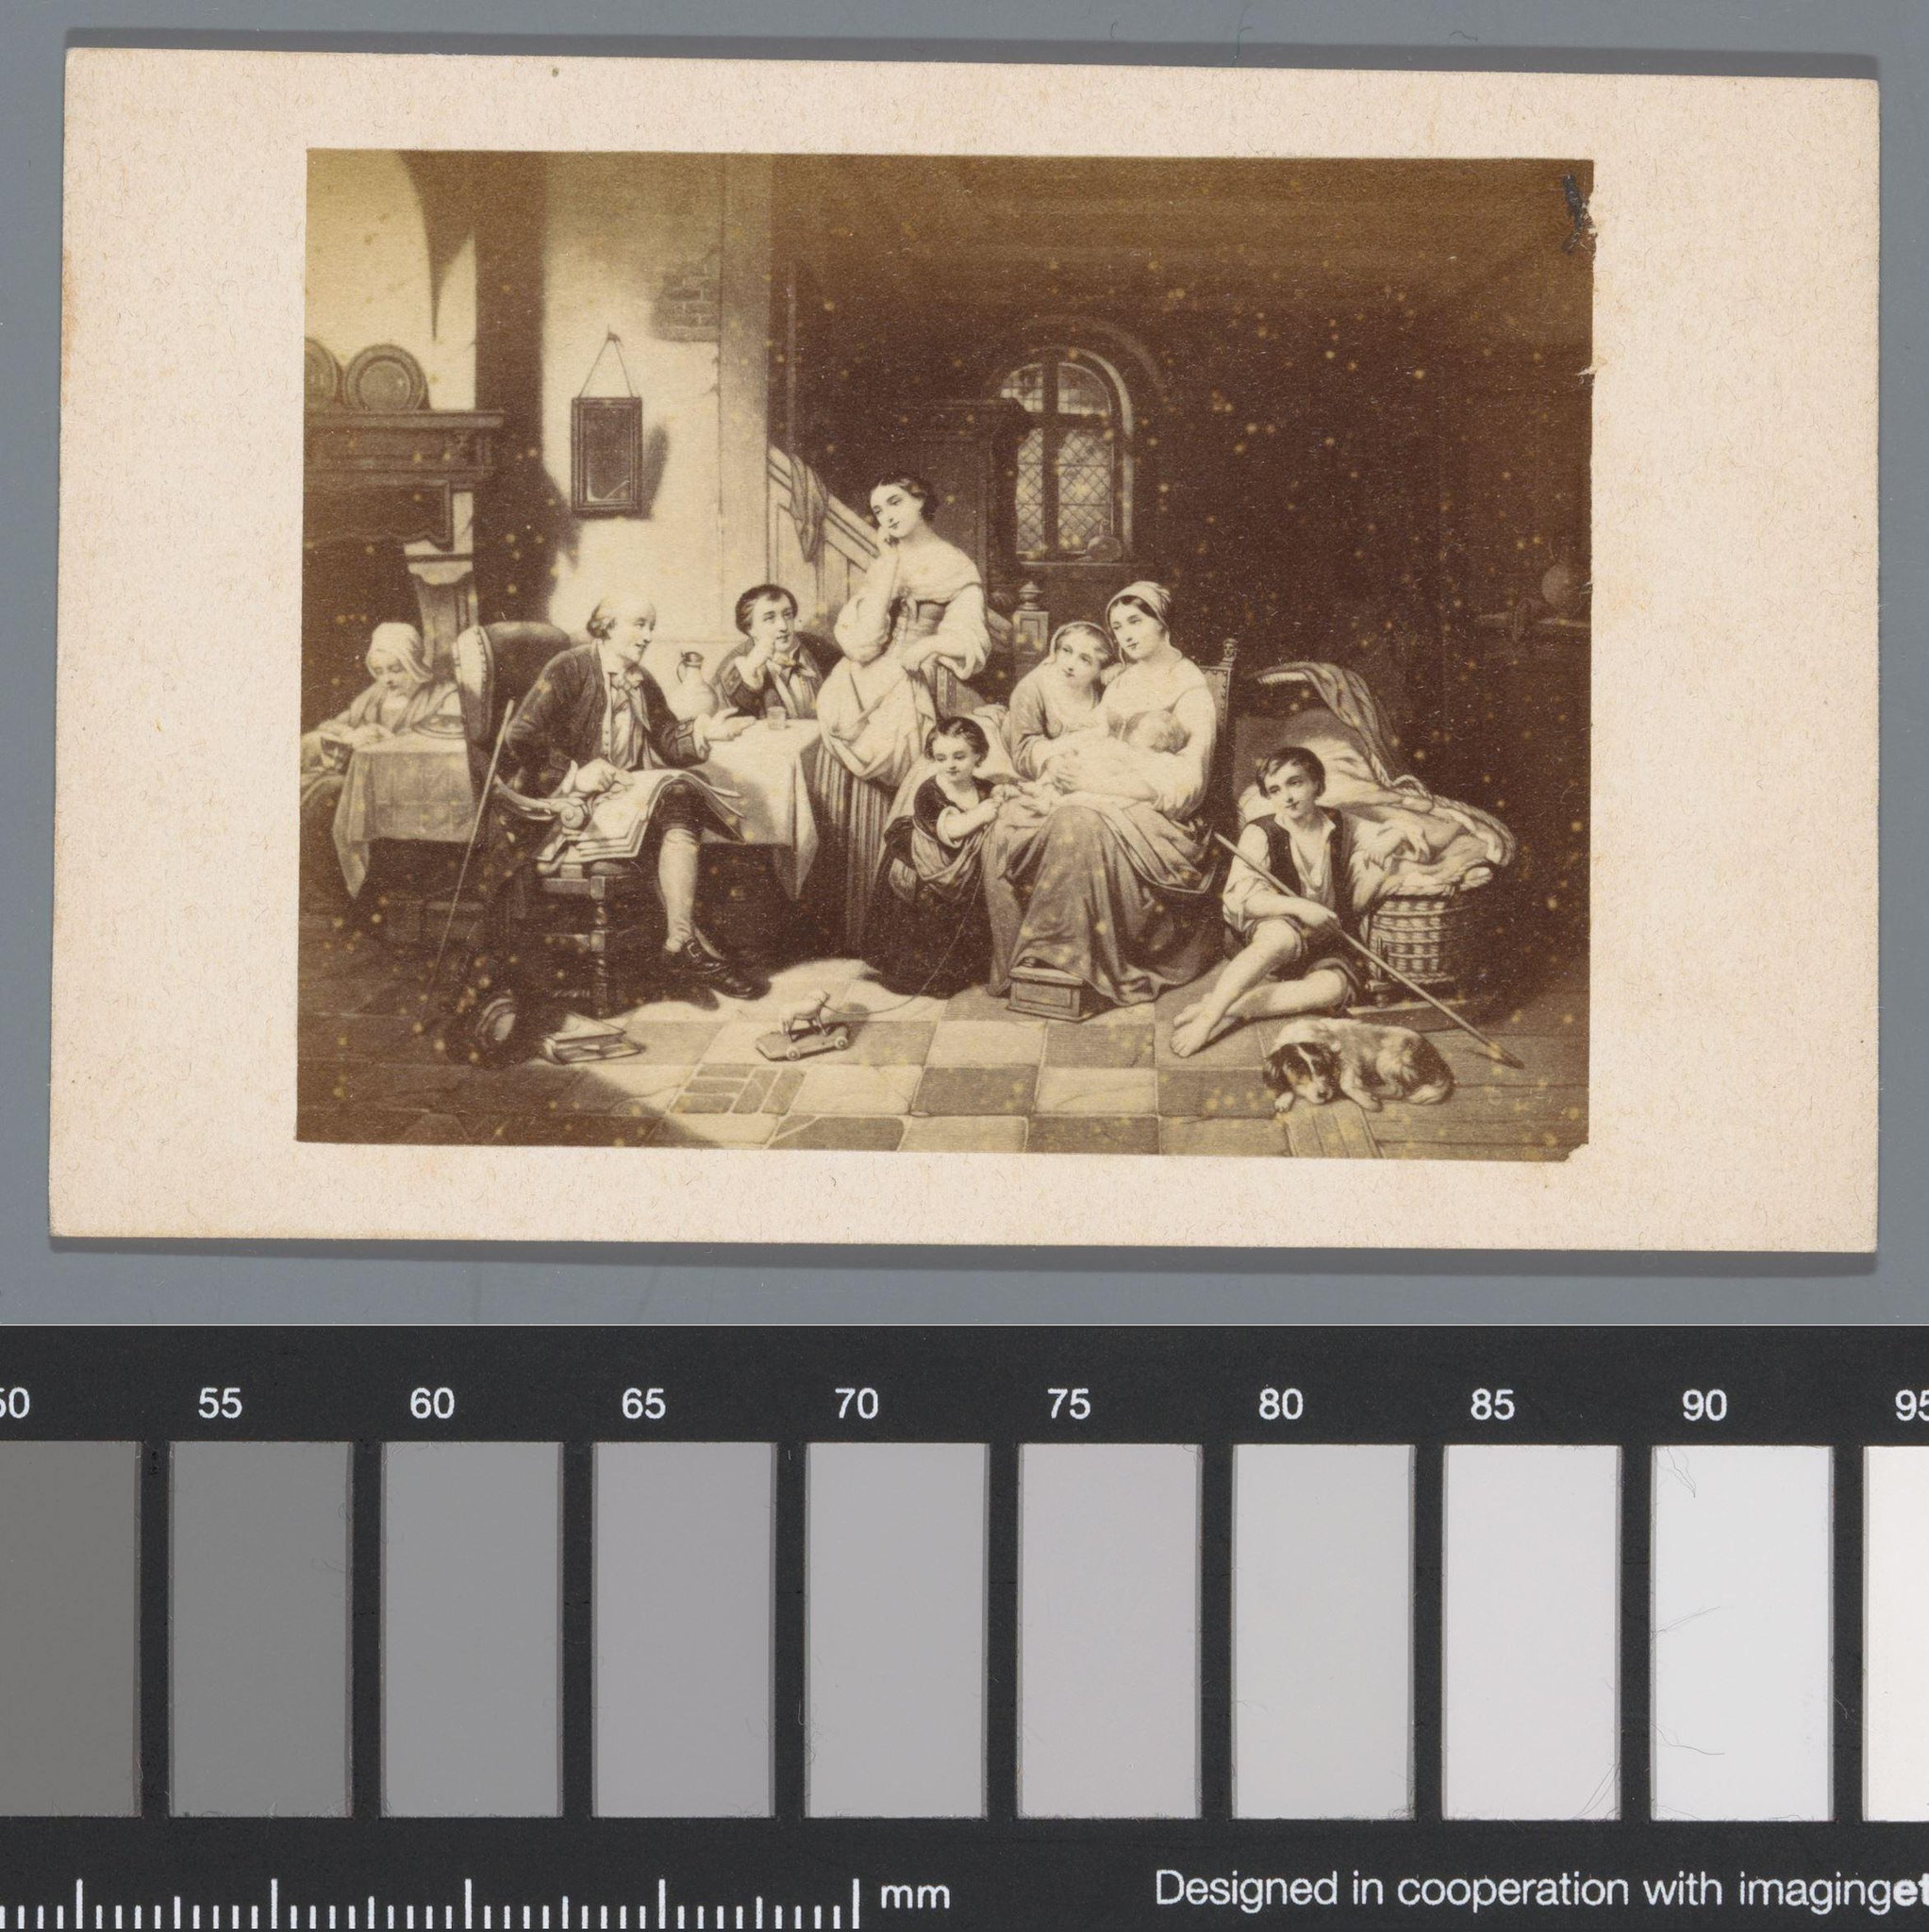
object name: carte de visite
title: Fotoreproductie van een schilderij naar het gedicht Huisgodsdienst door J.J.L. ten Kate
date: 1850-1900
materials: cardboard, photographic support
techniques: albumen print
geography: amsterdam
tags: reading the bible or other religious books, family life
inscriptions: inscription: ‘HUISGODSDIENST./ Als (...) stem gehoord!/ J. J. L. TEN KATE.’